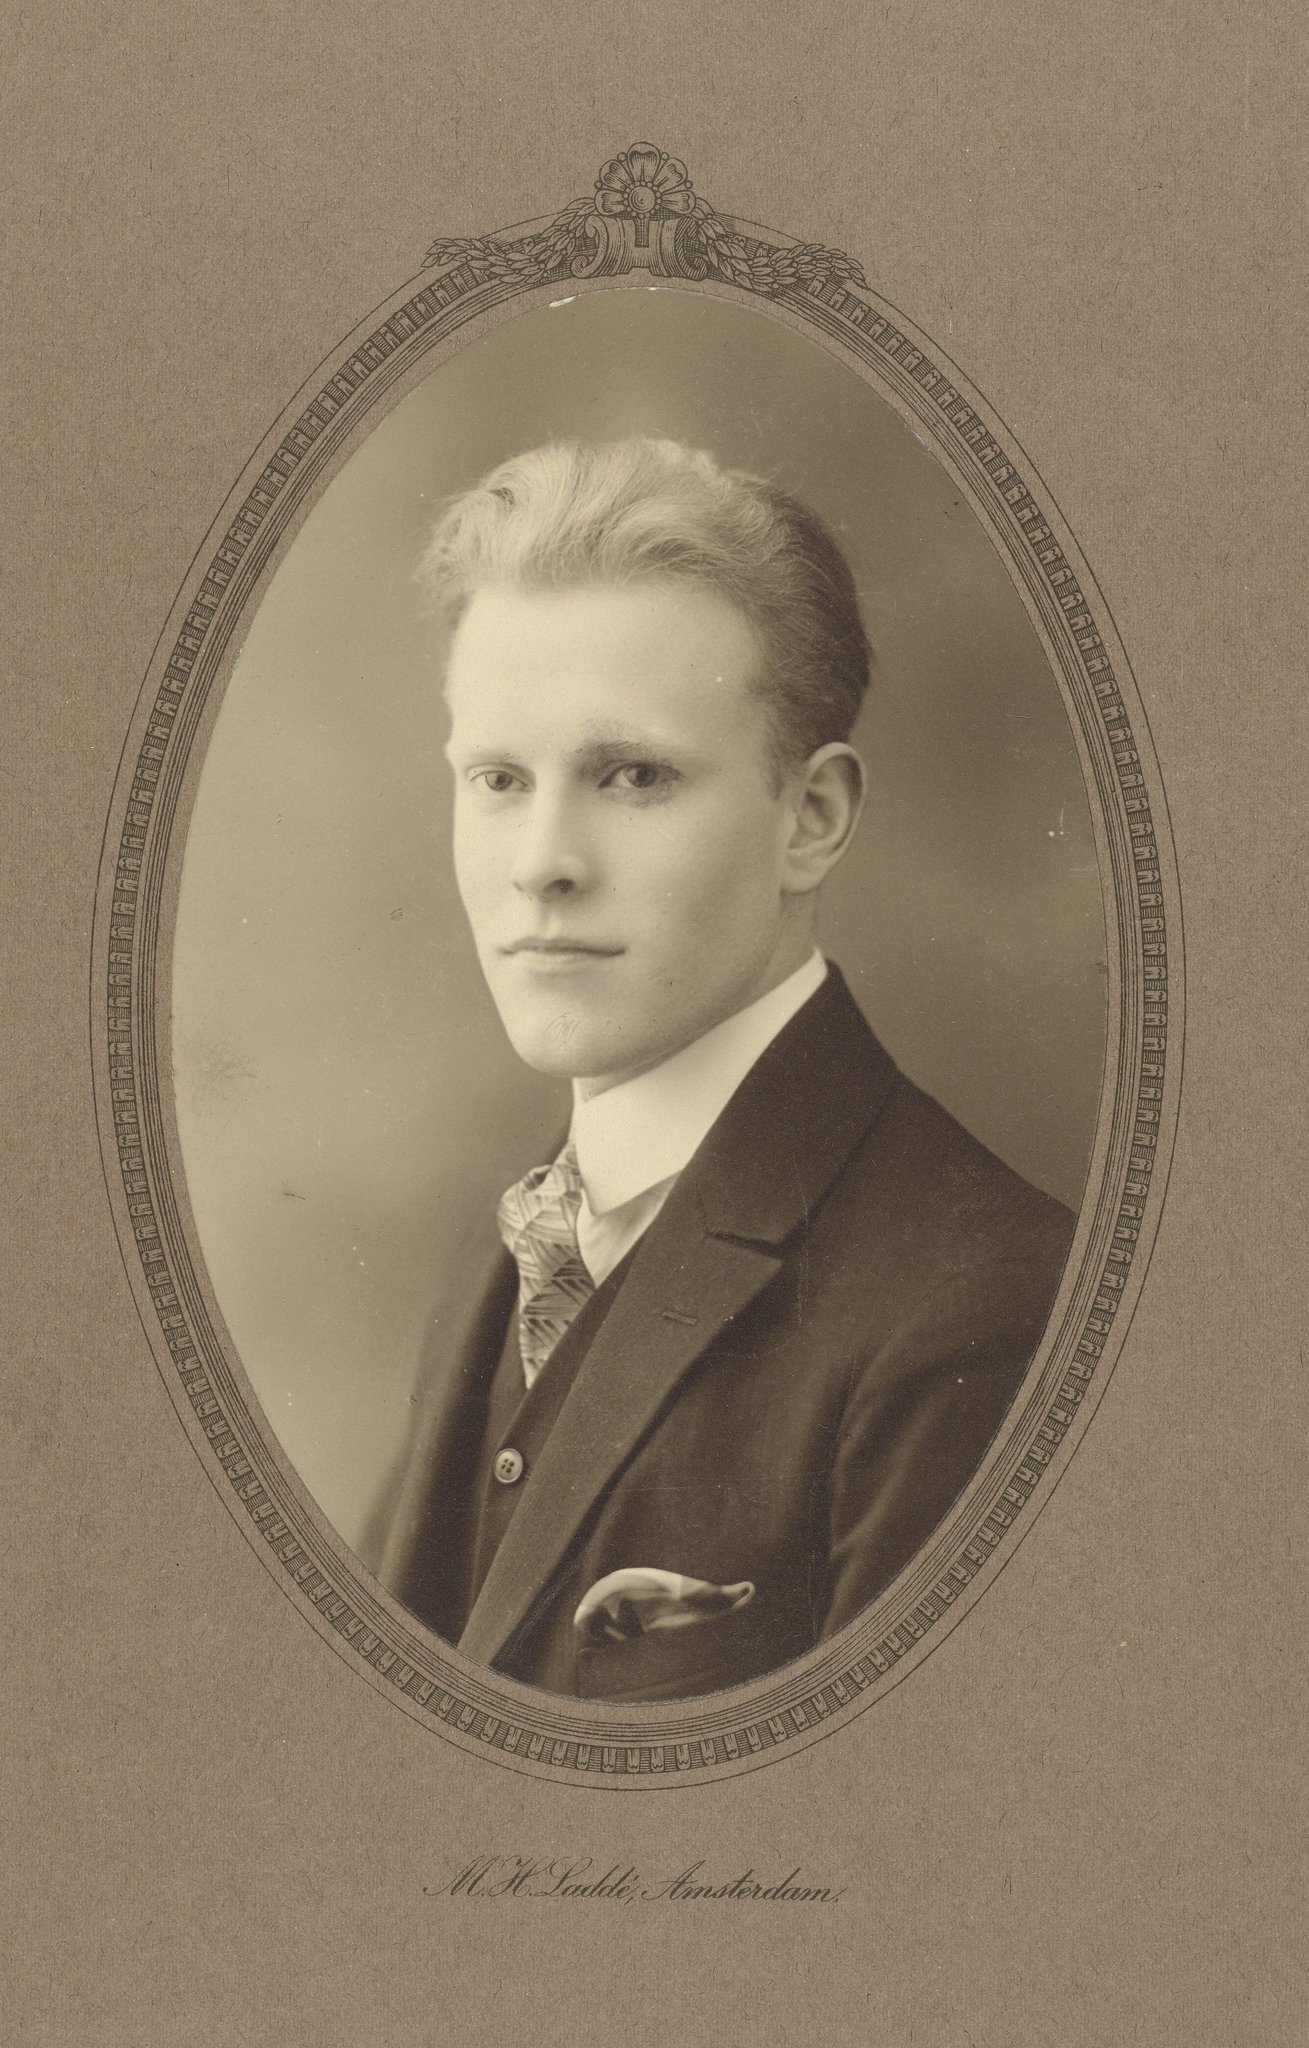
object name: photograph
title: Ovaal studioportret van een onbekende man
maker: machiel hendricus laddé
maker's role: fotograaf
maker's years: 1866-1932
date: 1915-1930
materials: cardboard, paper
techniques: gelatin silver print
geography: amsterdam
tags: historical persons not known by name, netherlands